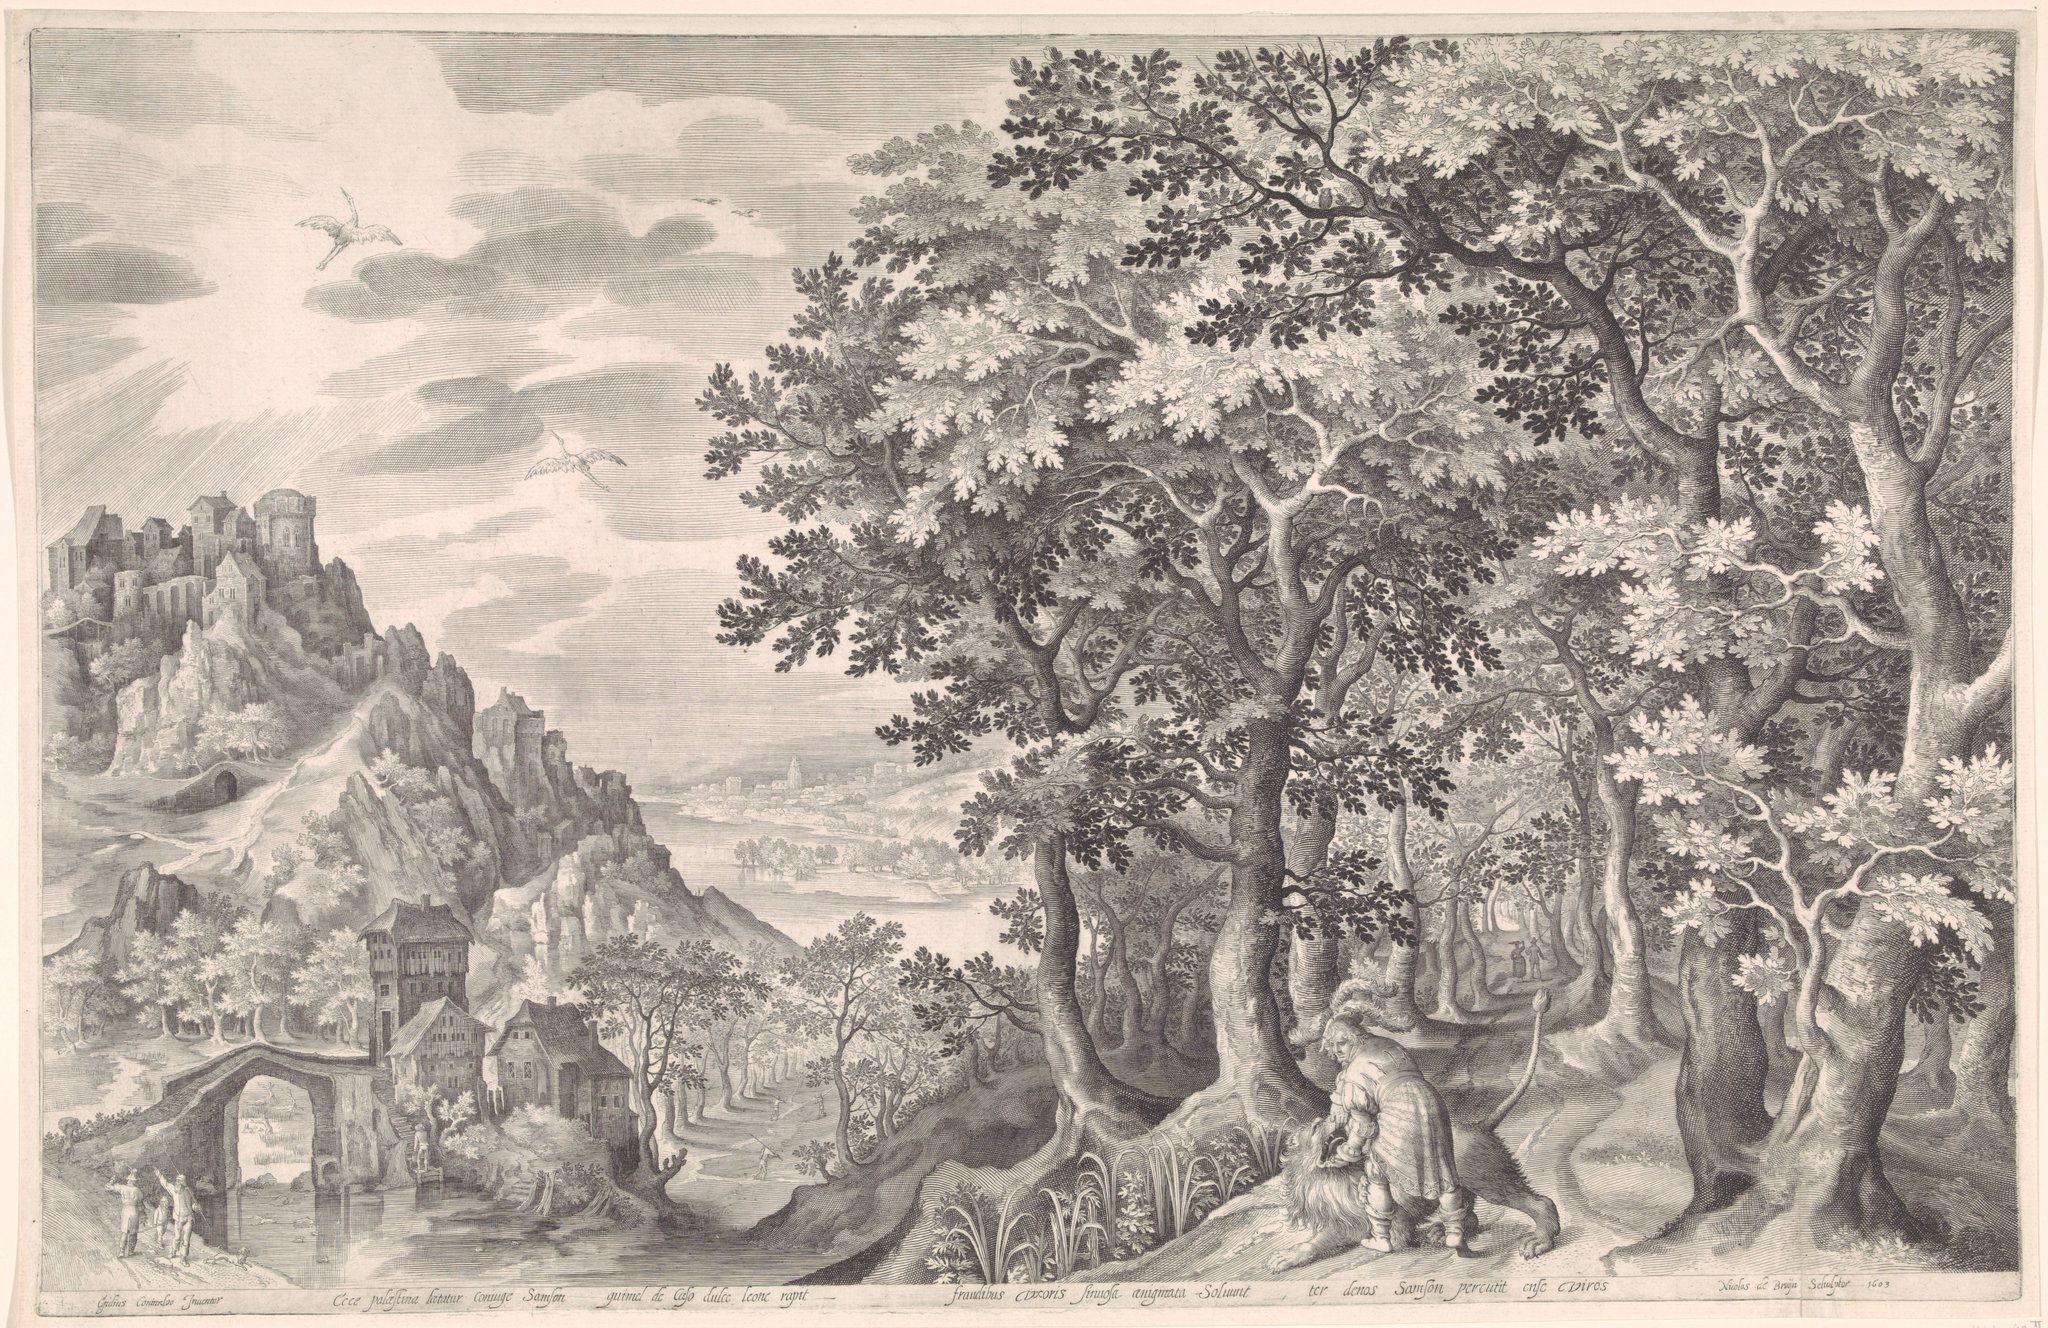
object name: print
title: Simson in gevecht met een leeuw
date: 1603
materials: paper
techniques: engraving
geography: antwerp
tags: samson kills the lion with his bare hands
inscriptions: date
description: Simson vecht met een leeuw in de buurt van de wijngaarden van Timna (Ri. 14:5-6). Op de achtergrond zijn ouders. De prent heeft een Latijns onderschrift met uitleg.